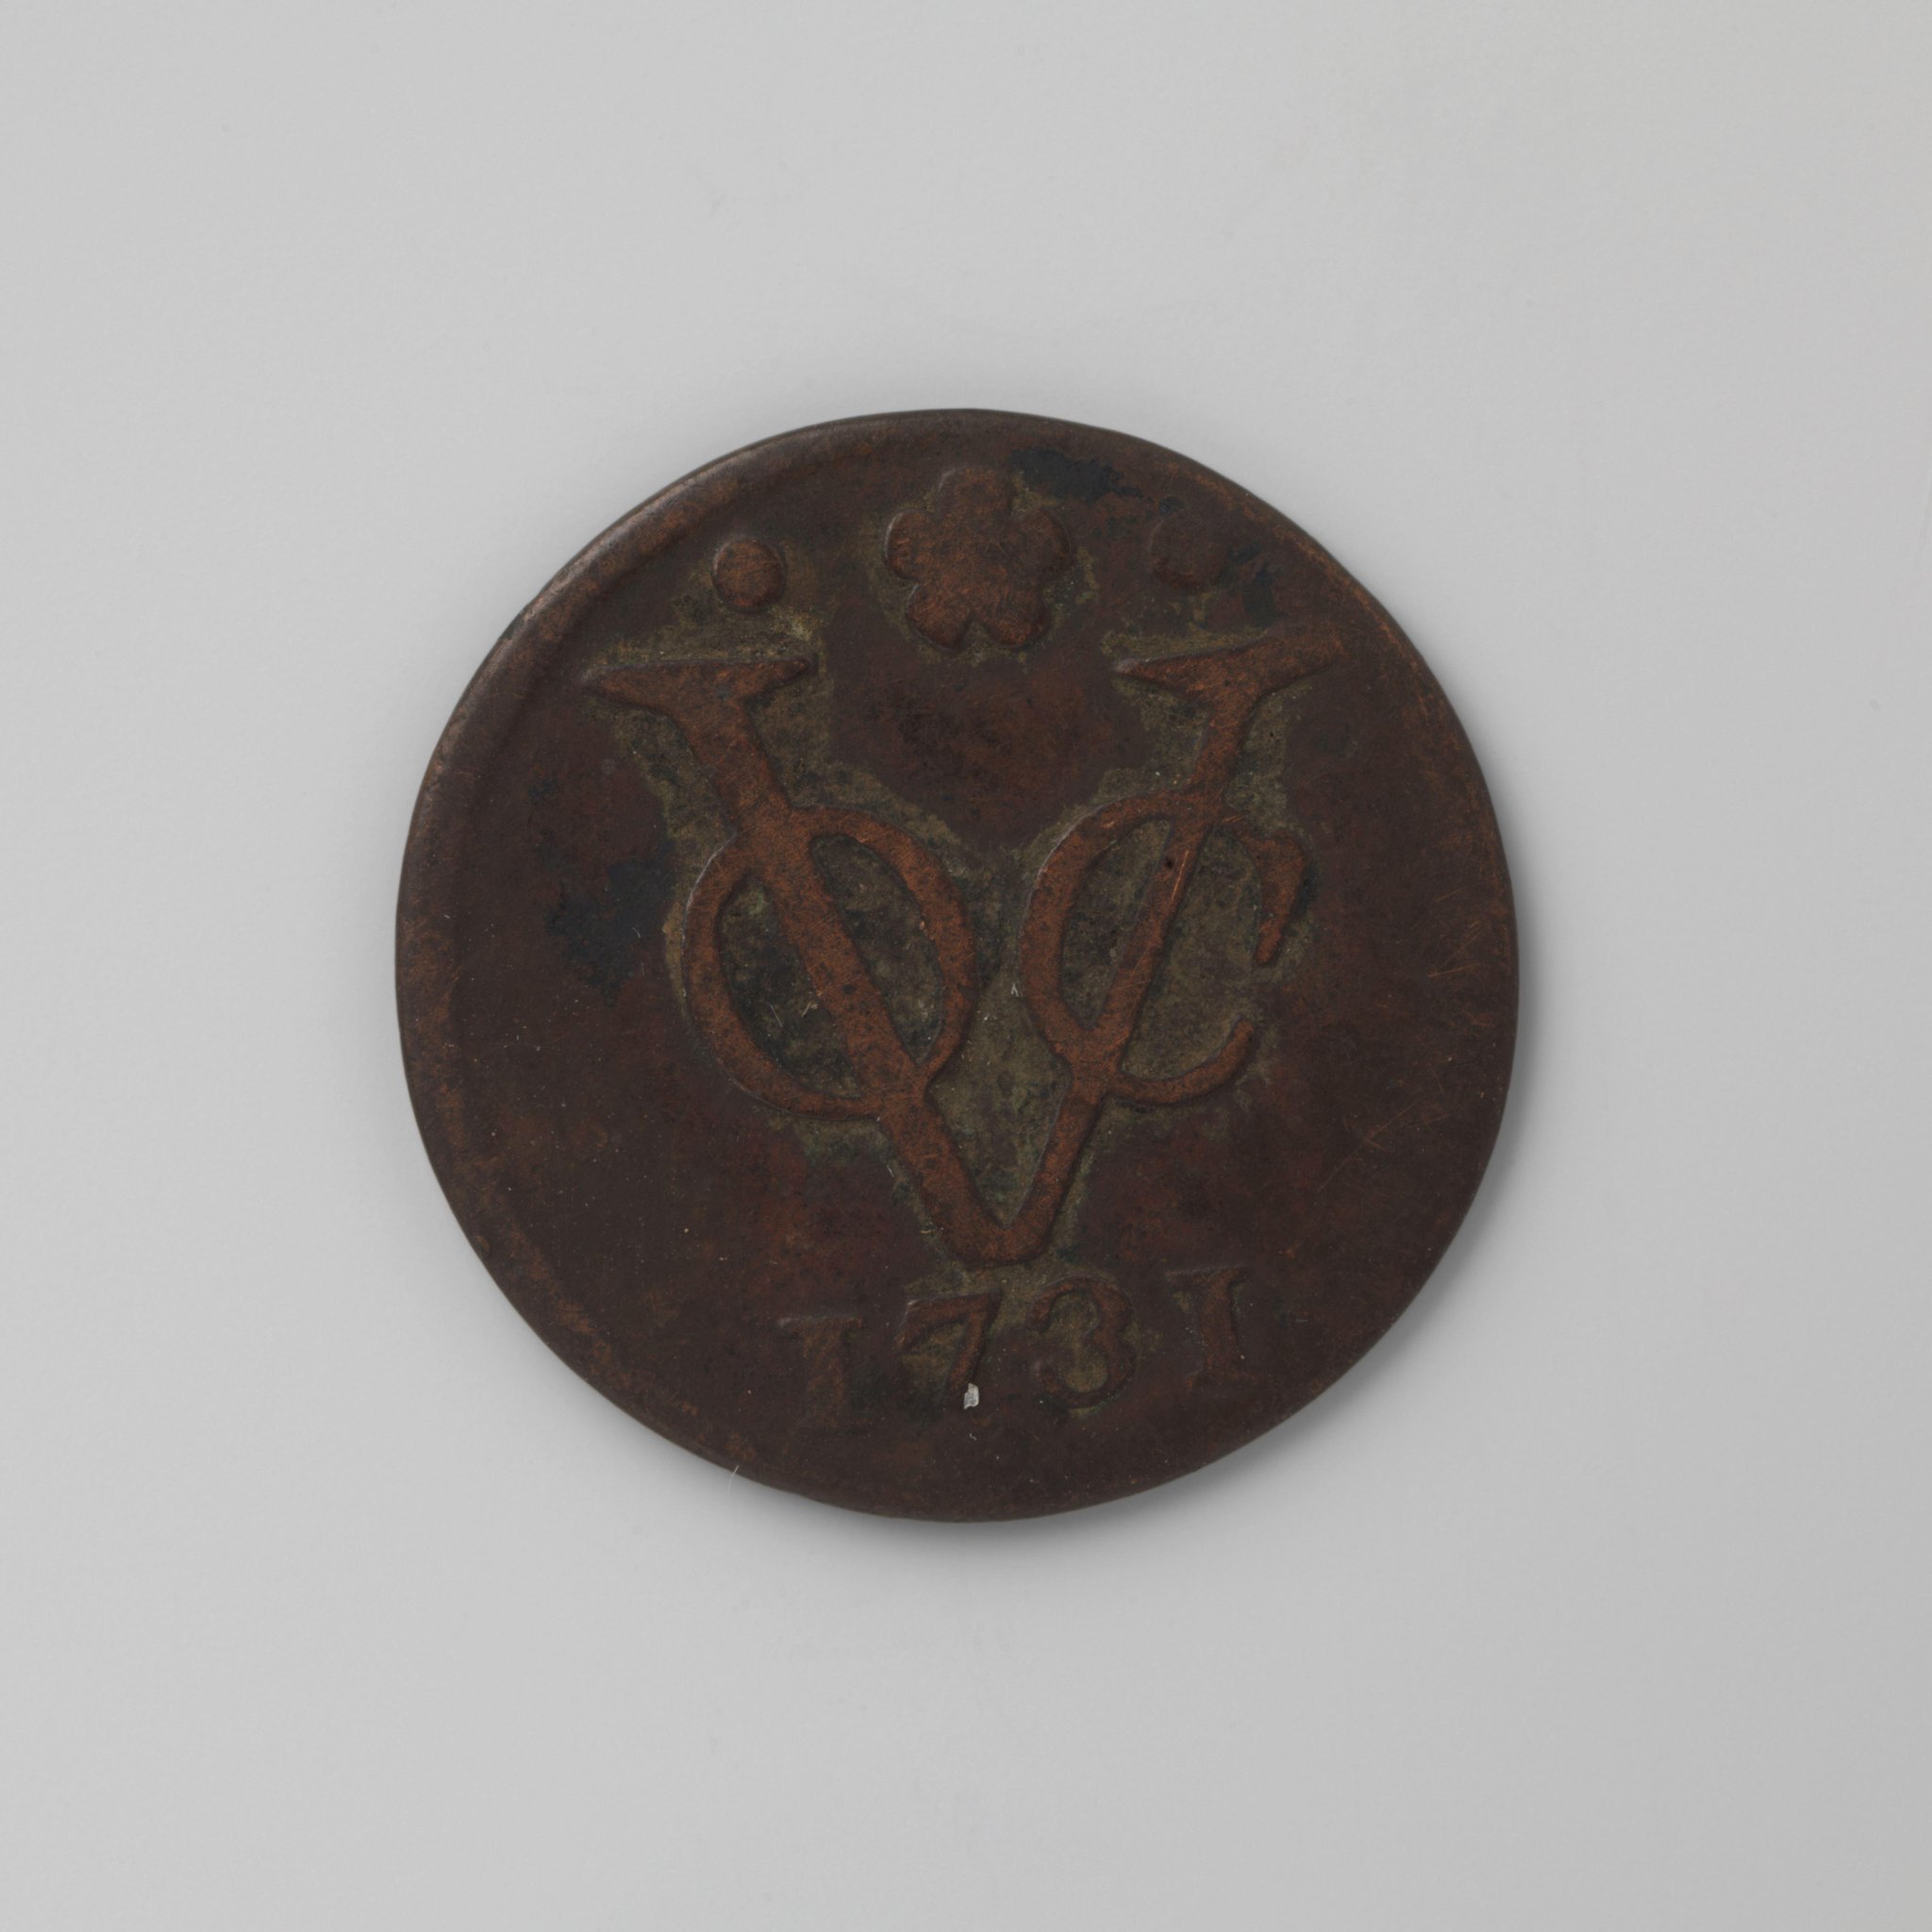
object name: coin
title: VOC, duit Holland, 1731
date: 1731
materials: copper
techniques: striking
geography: dordrecht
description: Koperen munt. Voorzijde: gekroond wapenschild van Holland. Keerzijde: monogram van de VOC, waarboven muntteken en waaronder jaartal. Gladde rand.